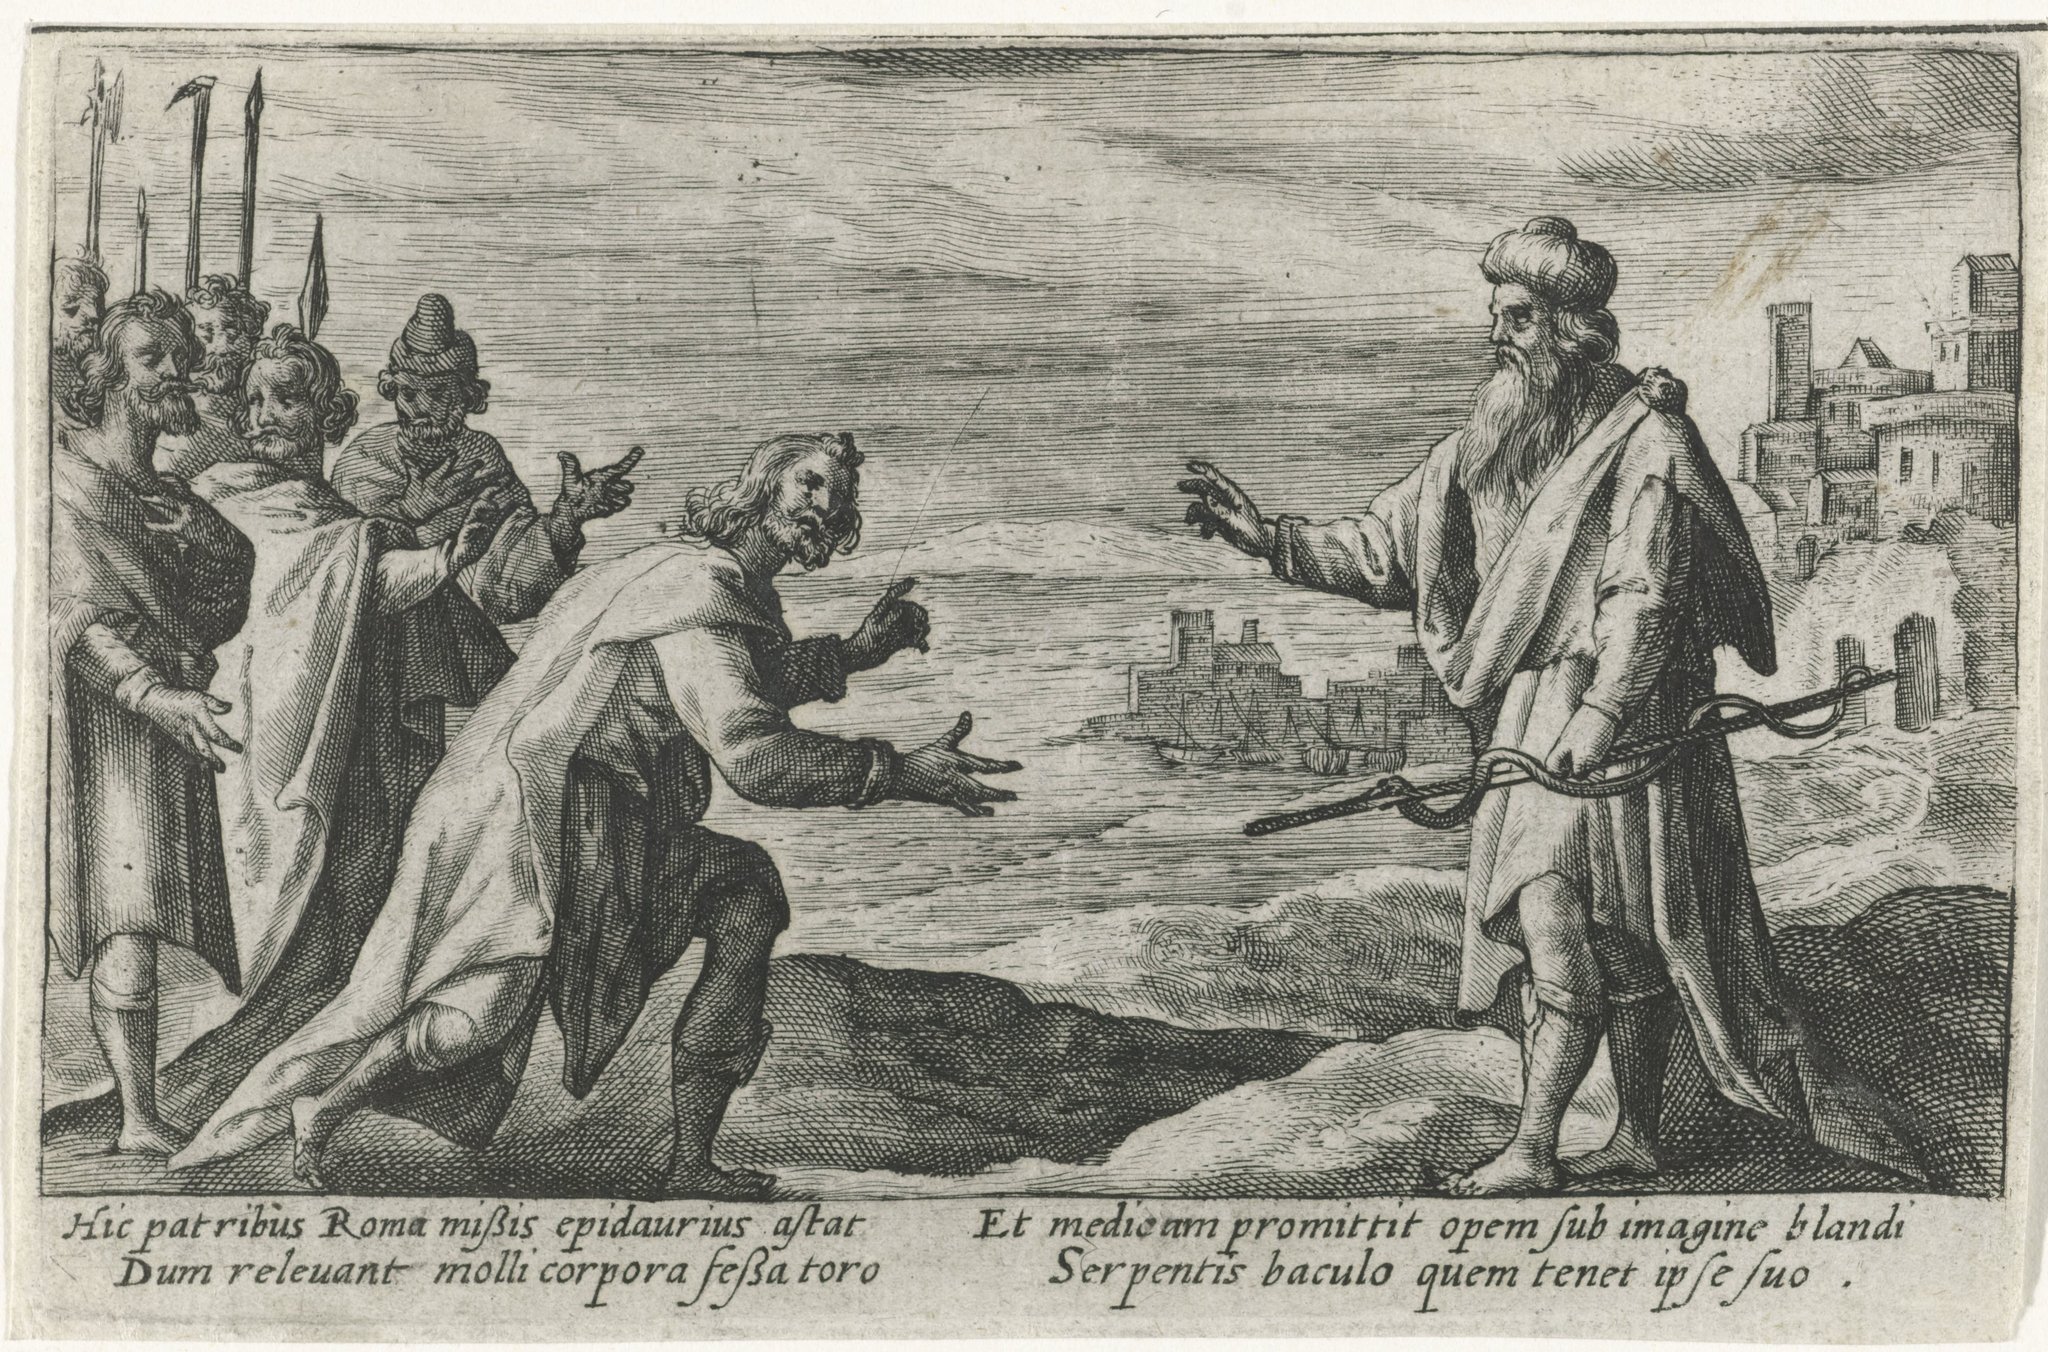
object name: print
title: Metamorfosen van Ovidius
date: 1602-1607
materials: paper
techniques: engraving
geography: cologne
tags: a roman embassy in the temple of aesculapius at epidaurus (+ variant)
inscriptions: collector's mark: Lugt 2228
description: Aesculapius, de zoon van Apollo, ontvangt de senaat uit Rome, die hem om verlossing vraagt. De god houdt in zijn linkerhand een herdersstaf waar een slang omheen kronkelt. Hij voorspelt de senatoren dat hij die gedaante zal aannemen. In de marge een vierregelig onderschrift, in twee kolommen, in het Latijn.